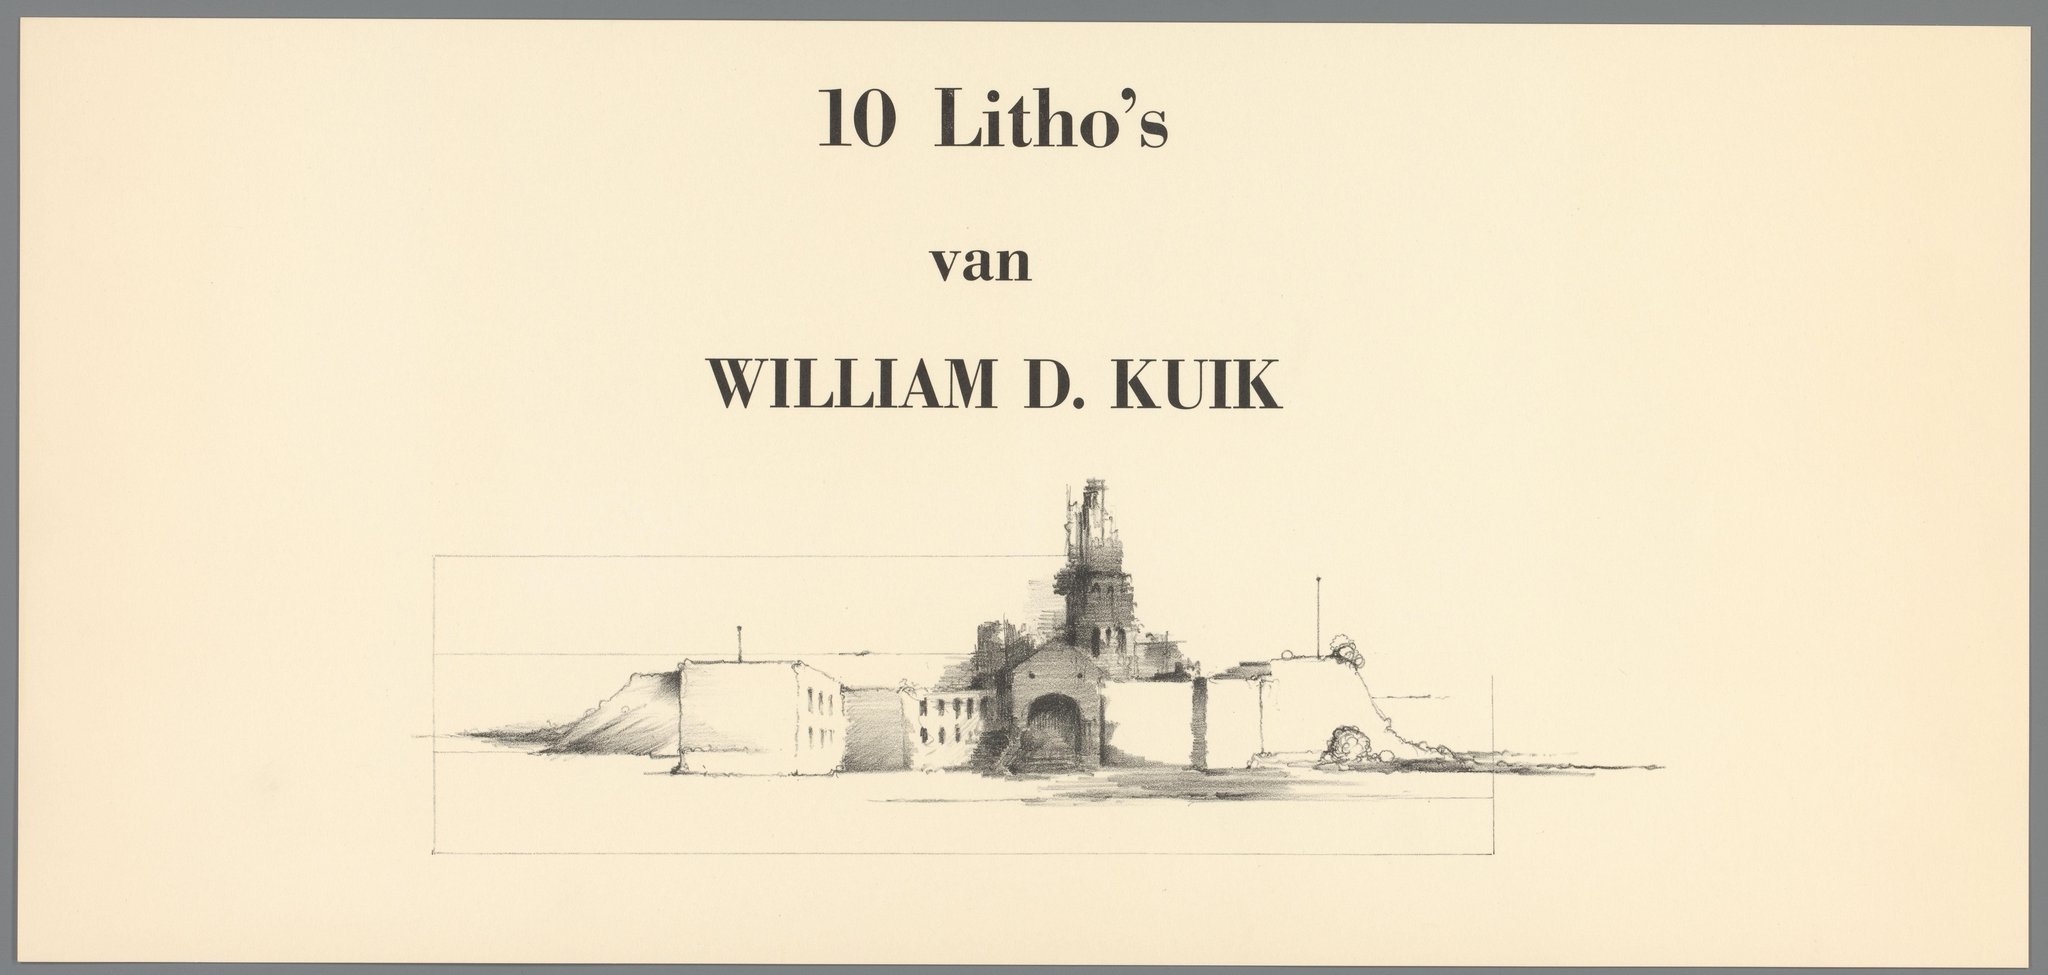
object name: titelblad, titelpagina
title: Tien gezichten op Utrecht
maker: dirkje kuik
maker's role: print maker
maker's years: 1929-2008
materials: ink, paper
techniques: letterpress printing, offset printed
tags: city-view in general; 'veduta' - ii - ideal city, utrecht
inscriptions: title: ‘10 Litho's van William D. Kuik’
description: Titelpagina met een schets naar een stadsmuur.